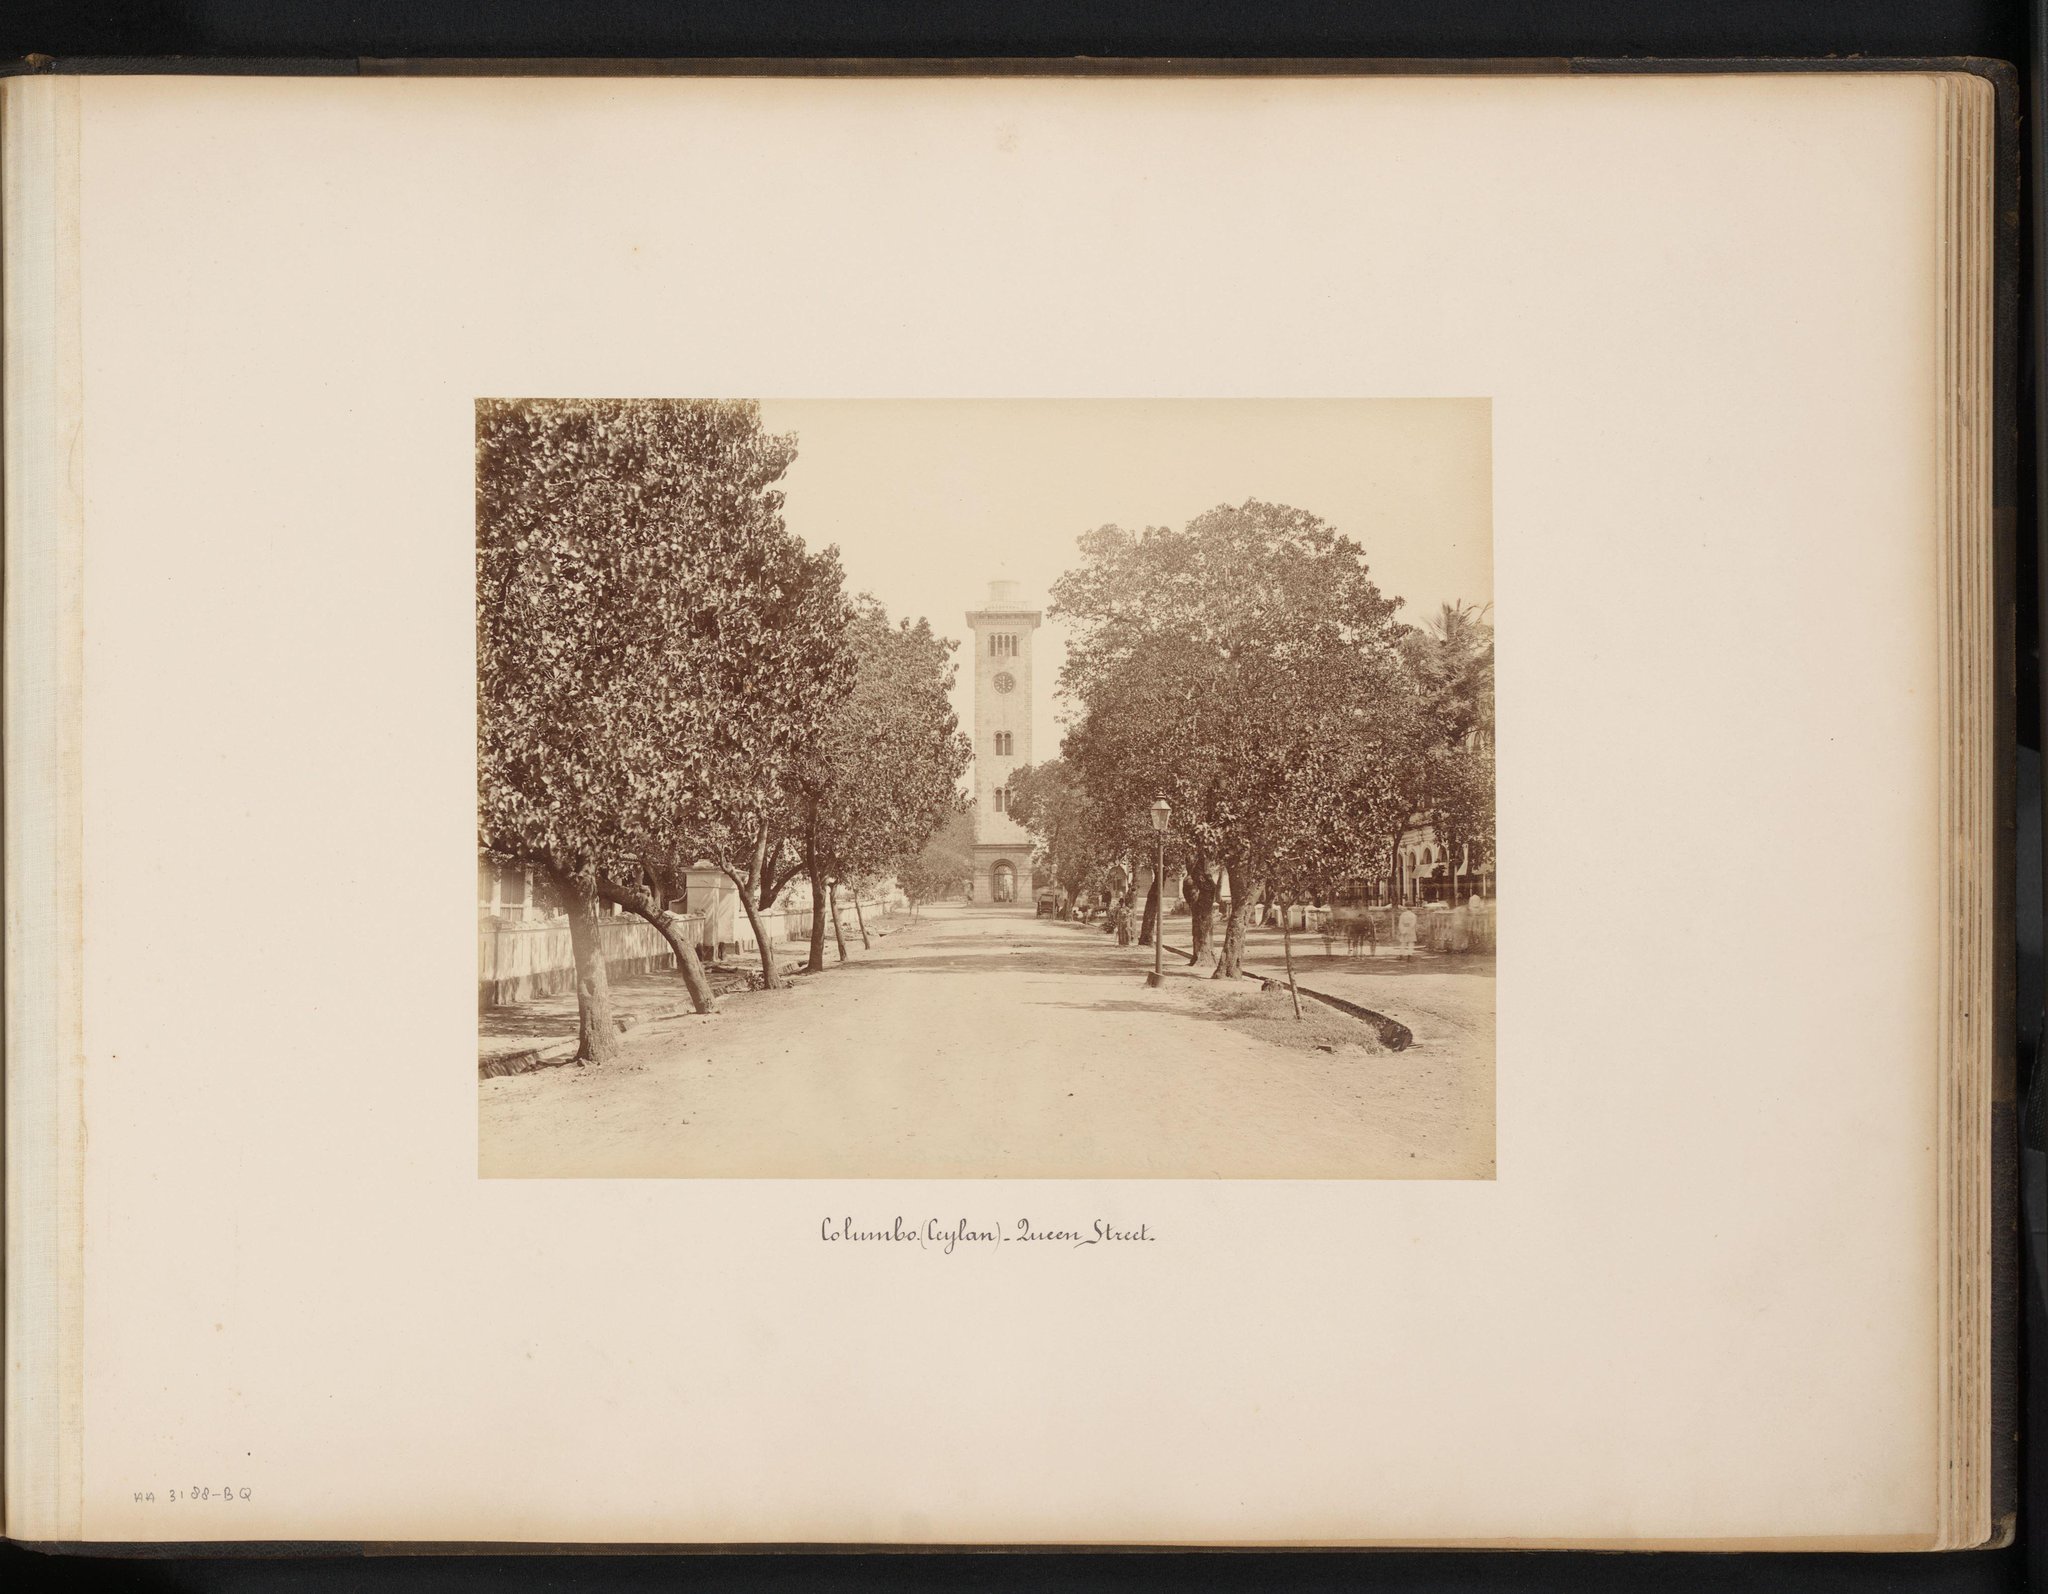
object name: photograph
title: View of the lighthouse in Queen Street, Colombo, Sri Lanka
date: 1880-1883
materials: photographic support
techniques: albumen print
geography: colombo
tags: lighthouse, lightship, street (+ city(-scape) with figures, staffage)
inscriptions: inscription: ‘Photographers W.L.H. Skeen & Co. Colombo Ceylon’, title: ‘Columbo. (Ceylan) _ Queen Street _’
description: Onderdeel van Reisalbum met opnames van bezienswaardigheden in Egypte, Nederlands-Indië, Singapore en Ceylon.